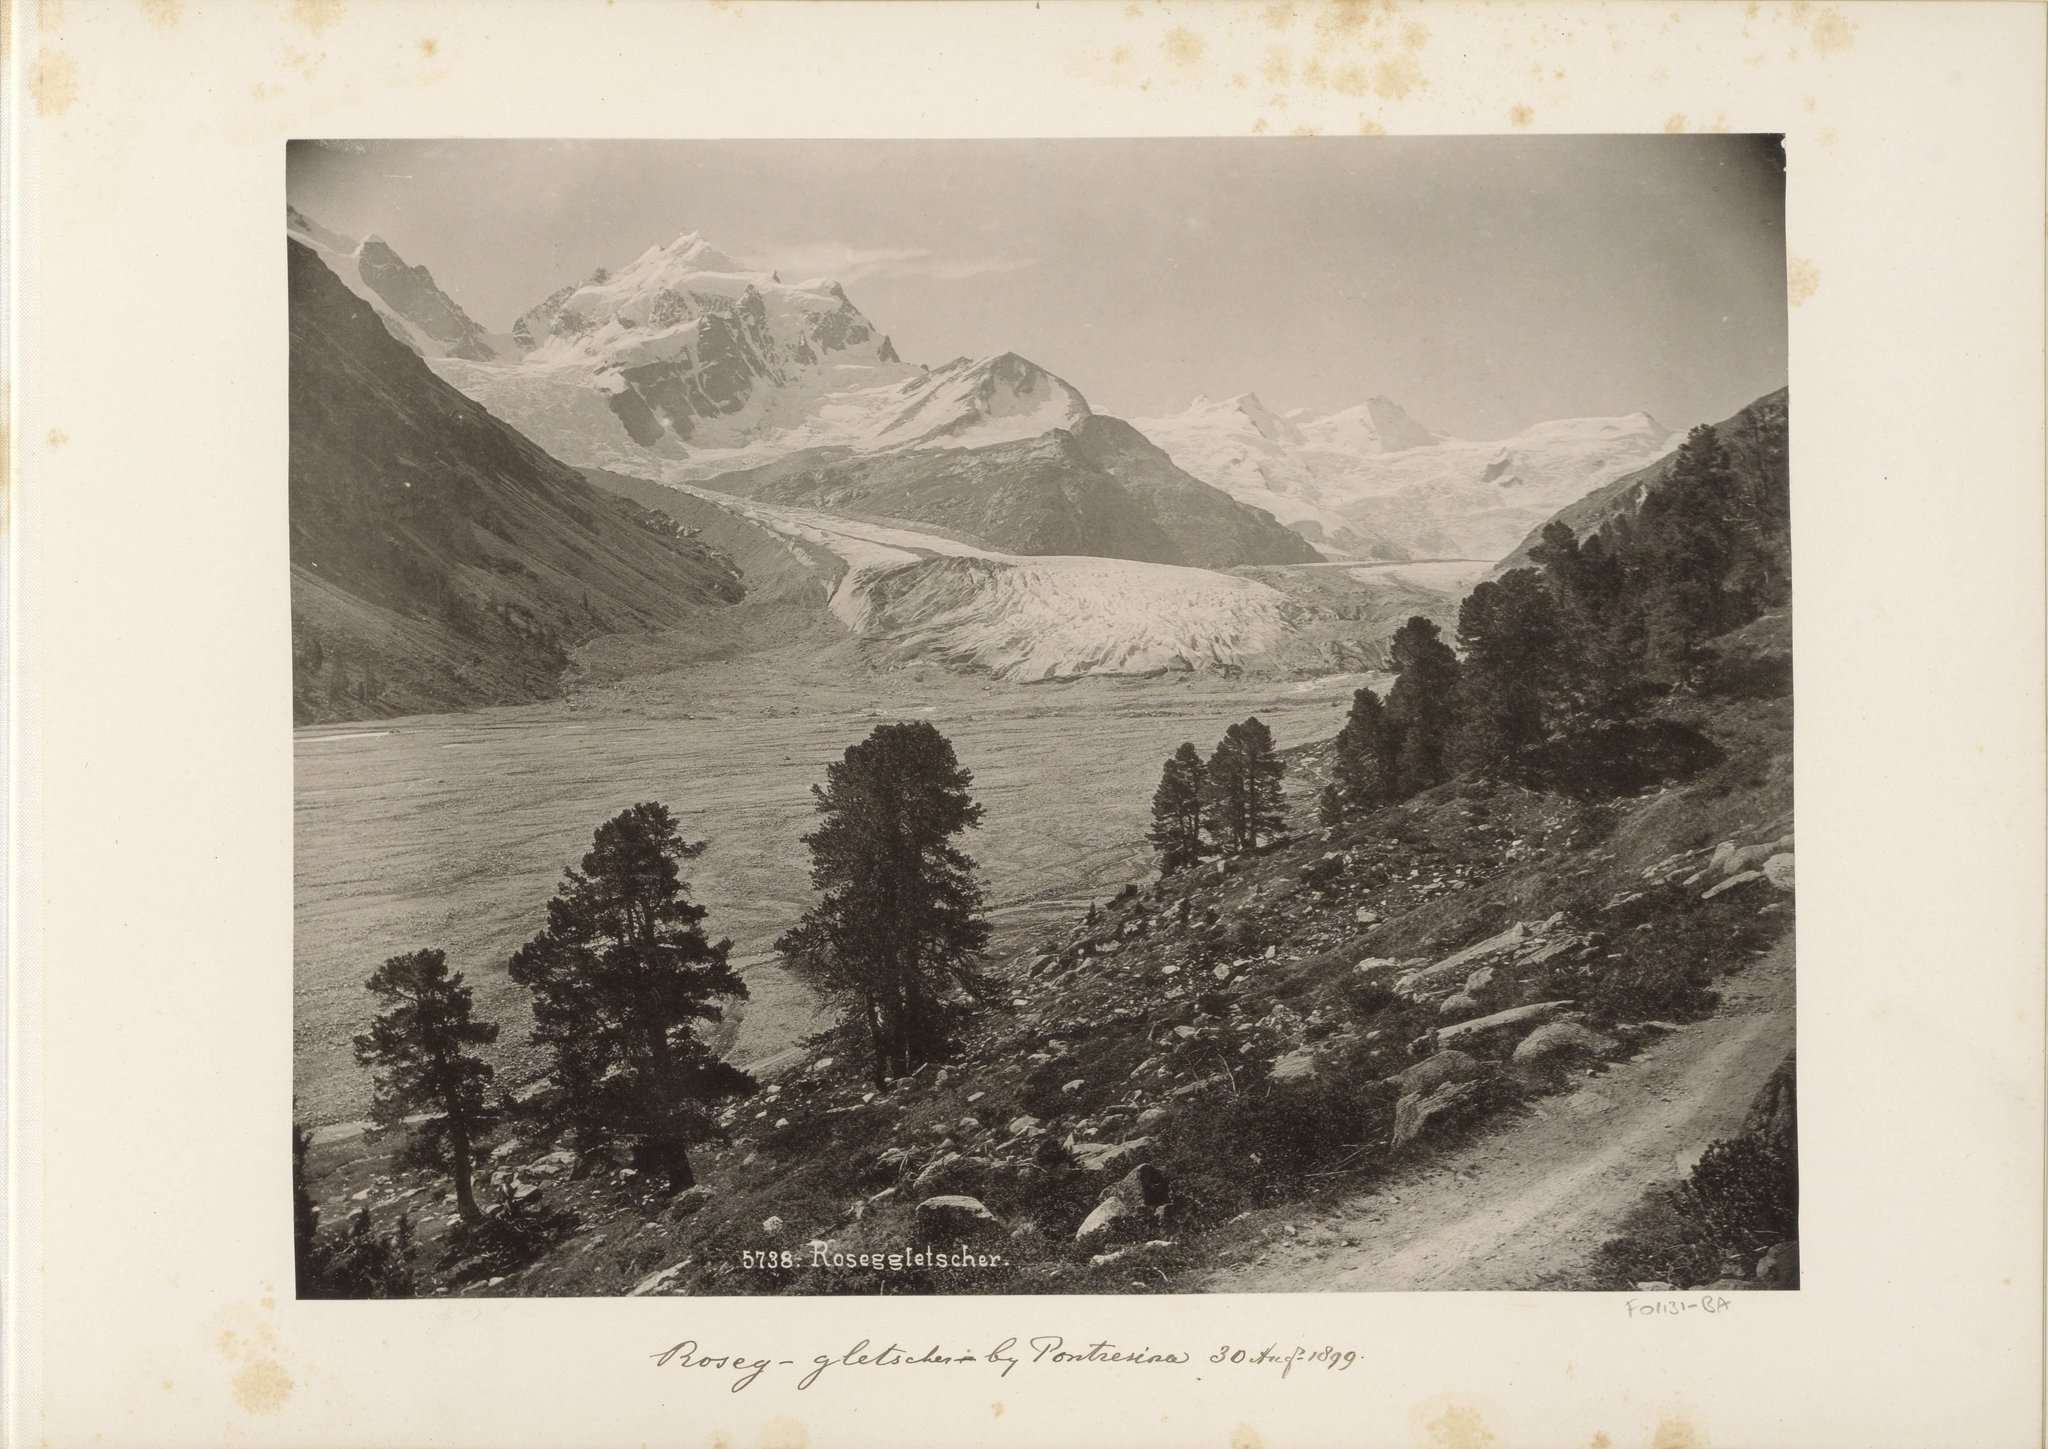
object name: album leaf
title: Gezicht op de Roseggletsjer bij Pontresina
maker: Anonymous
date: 1880-1899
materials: paper, photographic support, ink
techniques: photograph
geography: pontresina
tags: glacier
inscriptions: number: ‘5738’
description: Onderdeel van Reisalbum met bezienswaardigheden in Duitsland, Oostenrijk, Zwitserland, Luxemburg en België.